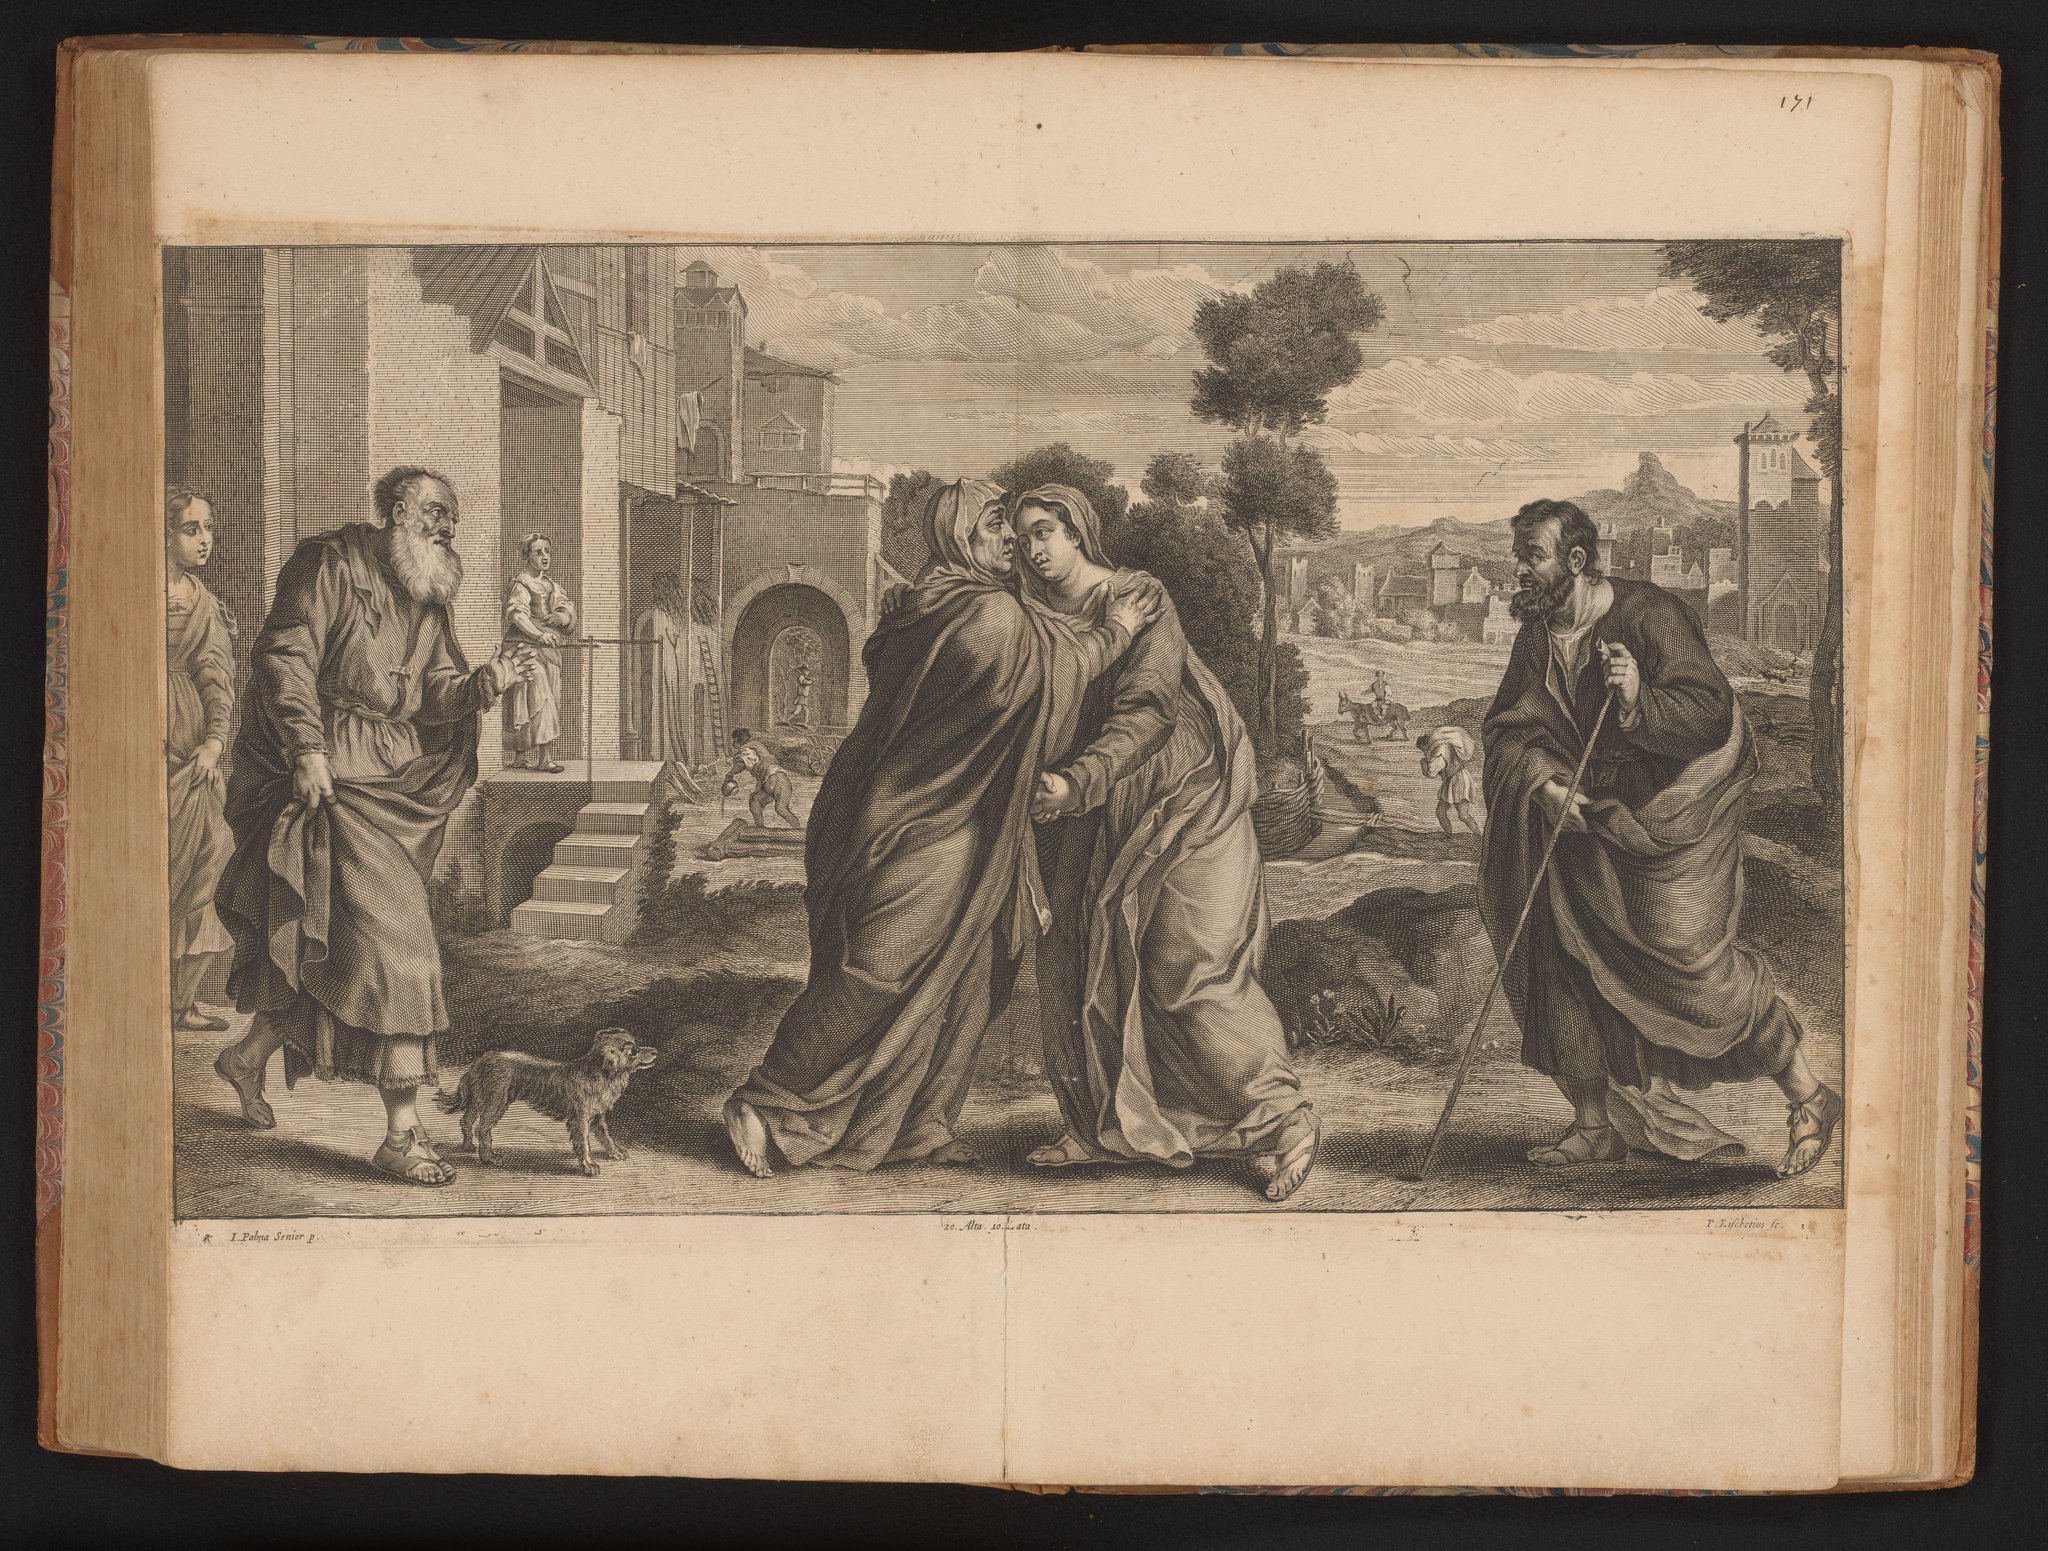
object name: album leaf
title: Visitatie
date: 1660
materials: paper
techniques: engraving, etching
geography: antwerp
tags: mary and elisabeth, both pregnant, embracing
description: De prent is vervaardigd naar het schilderij van Palma dat zich in de collectie van het Kunsthistorisches Museum te Wenen bevindt (inventarisnummer GG_56). David Teniers heeft waarschijnlijk van alle schilderijen uit de collectie van Leopold Willem van Oostenrijk een olieverfstudie op doek of paneel vervaardigd (zgn. pasticcio), die als voorbeeld voor de prentmakers diende. Het is niet altijd duidelijk of de pasticci door hem zijn gemaakt of door zijn atelier. Niet alle pasticci zijn overgeleverd.